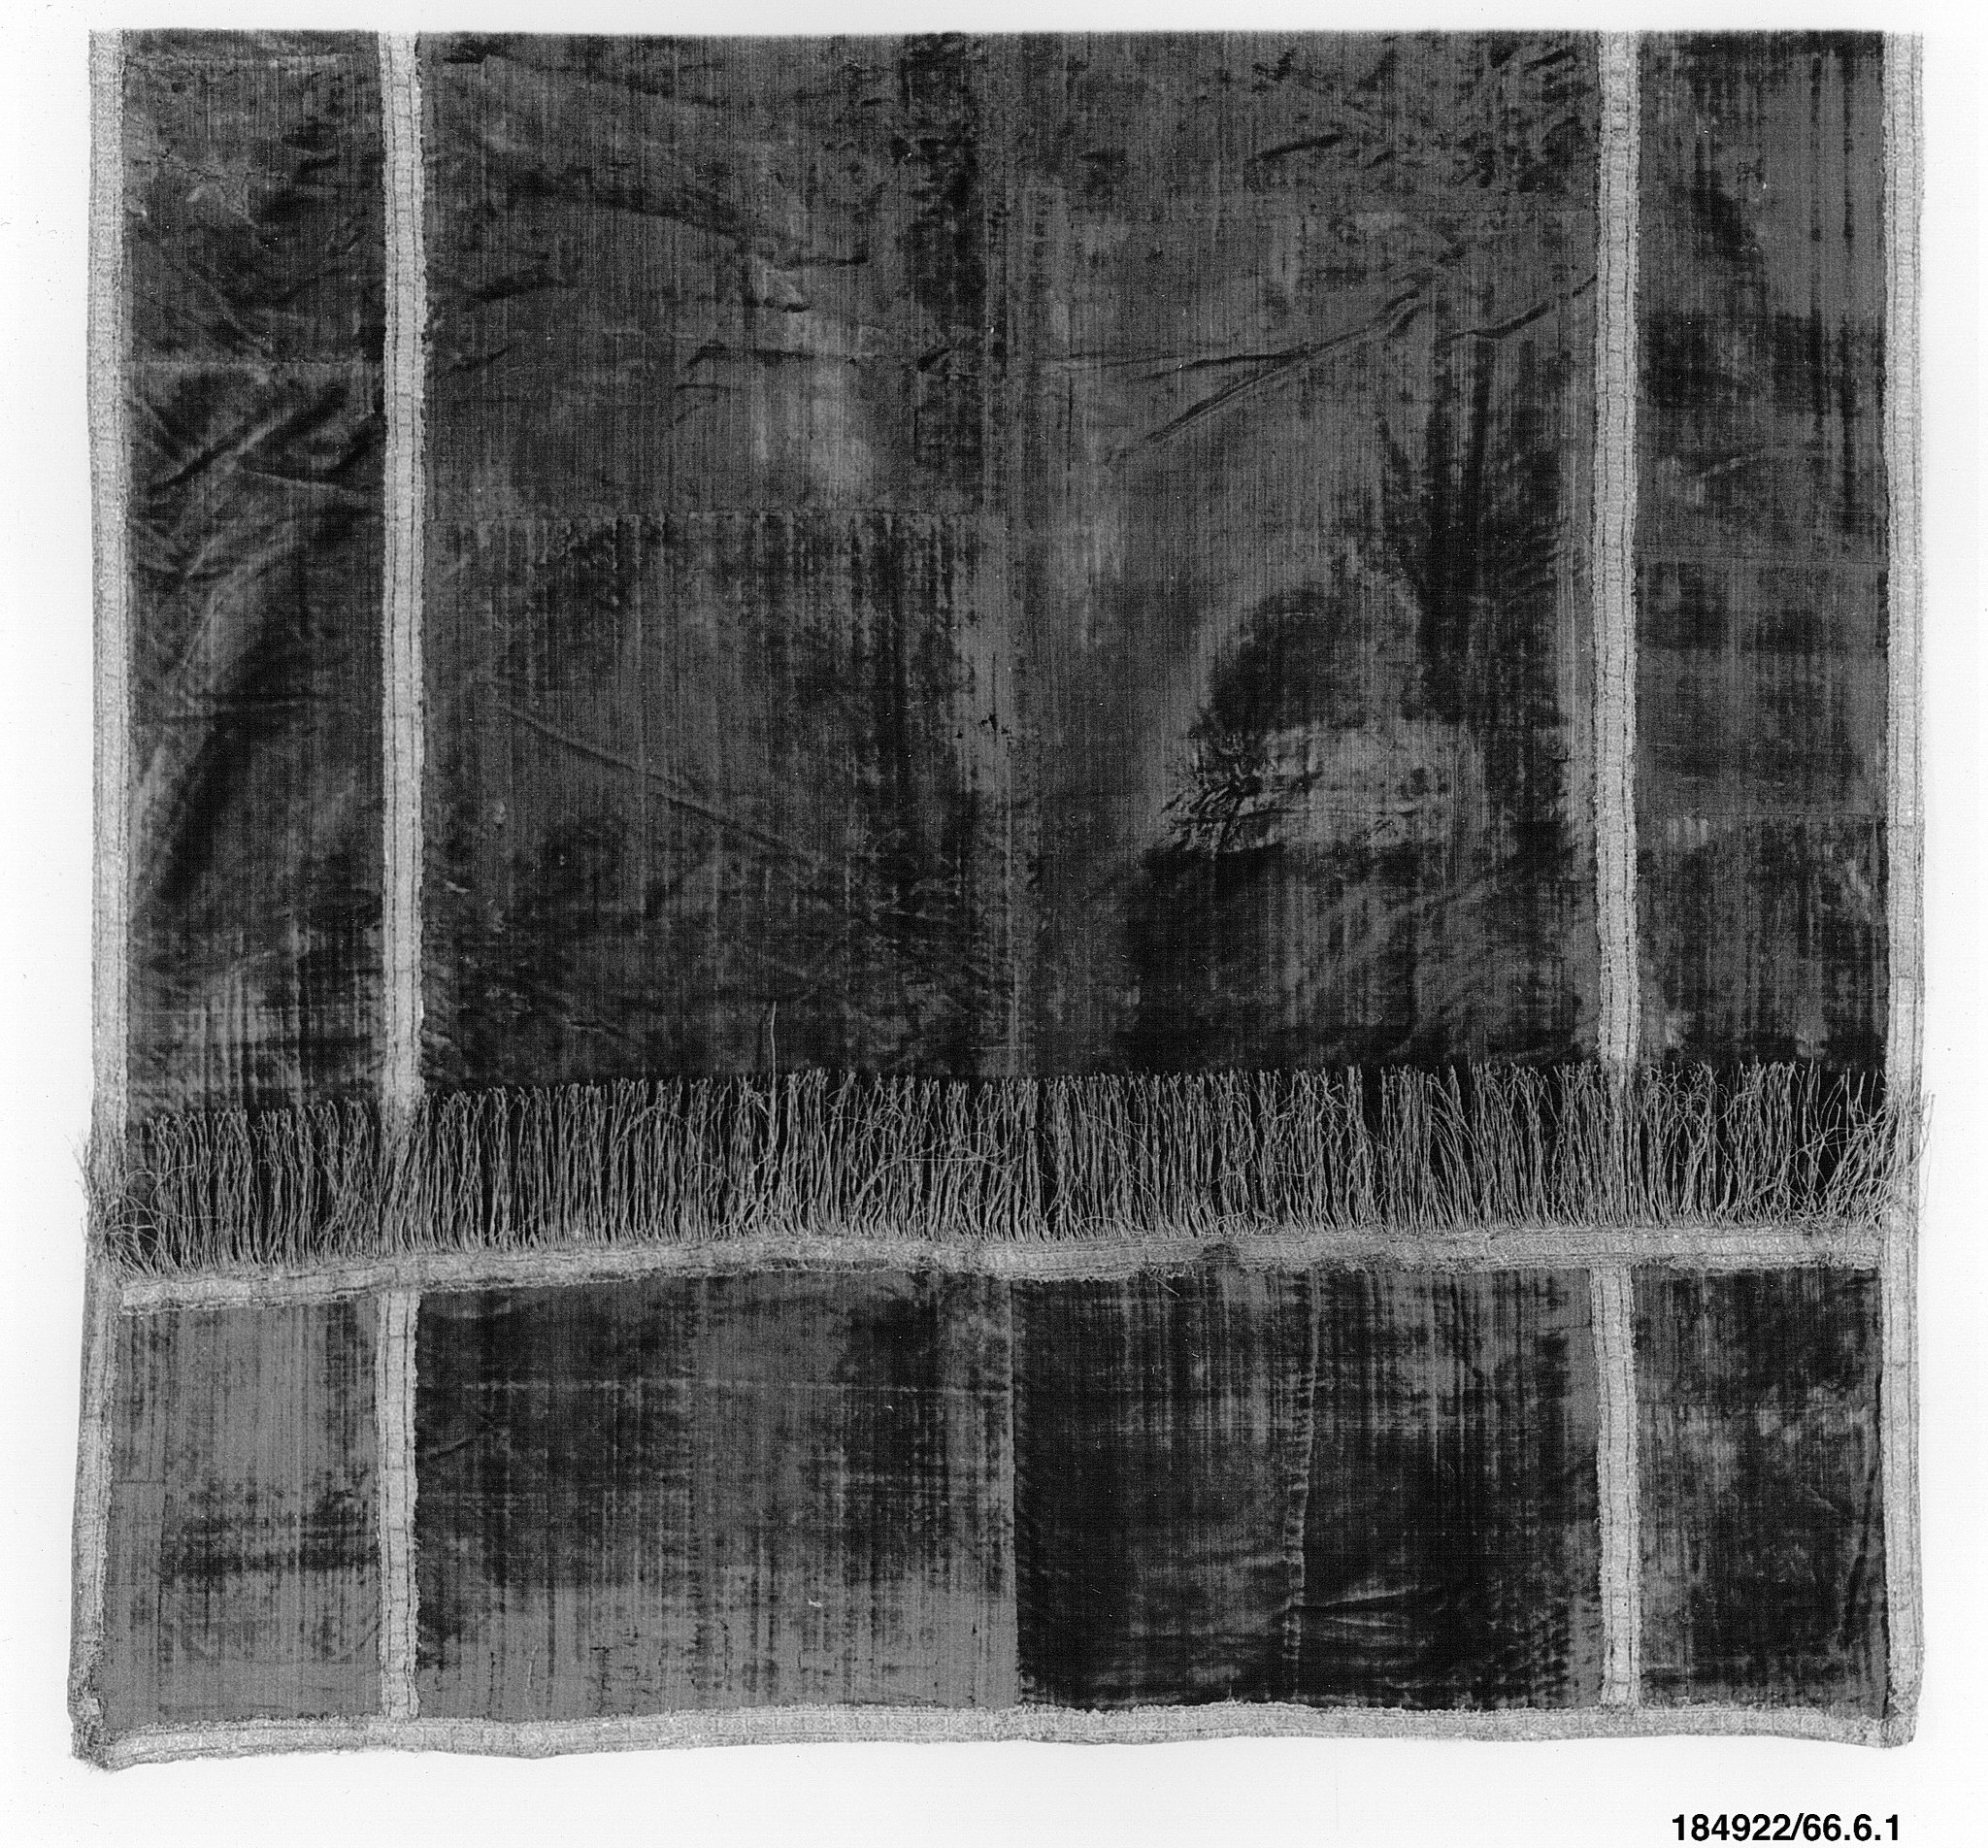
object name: panel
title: Panels (2)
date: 1601-1700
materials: metal thread, silk